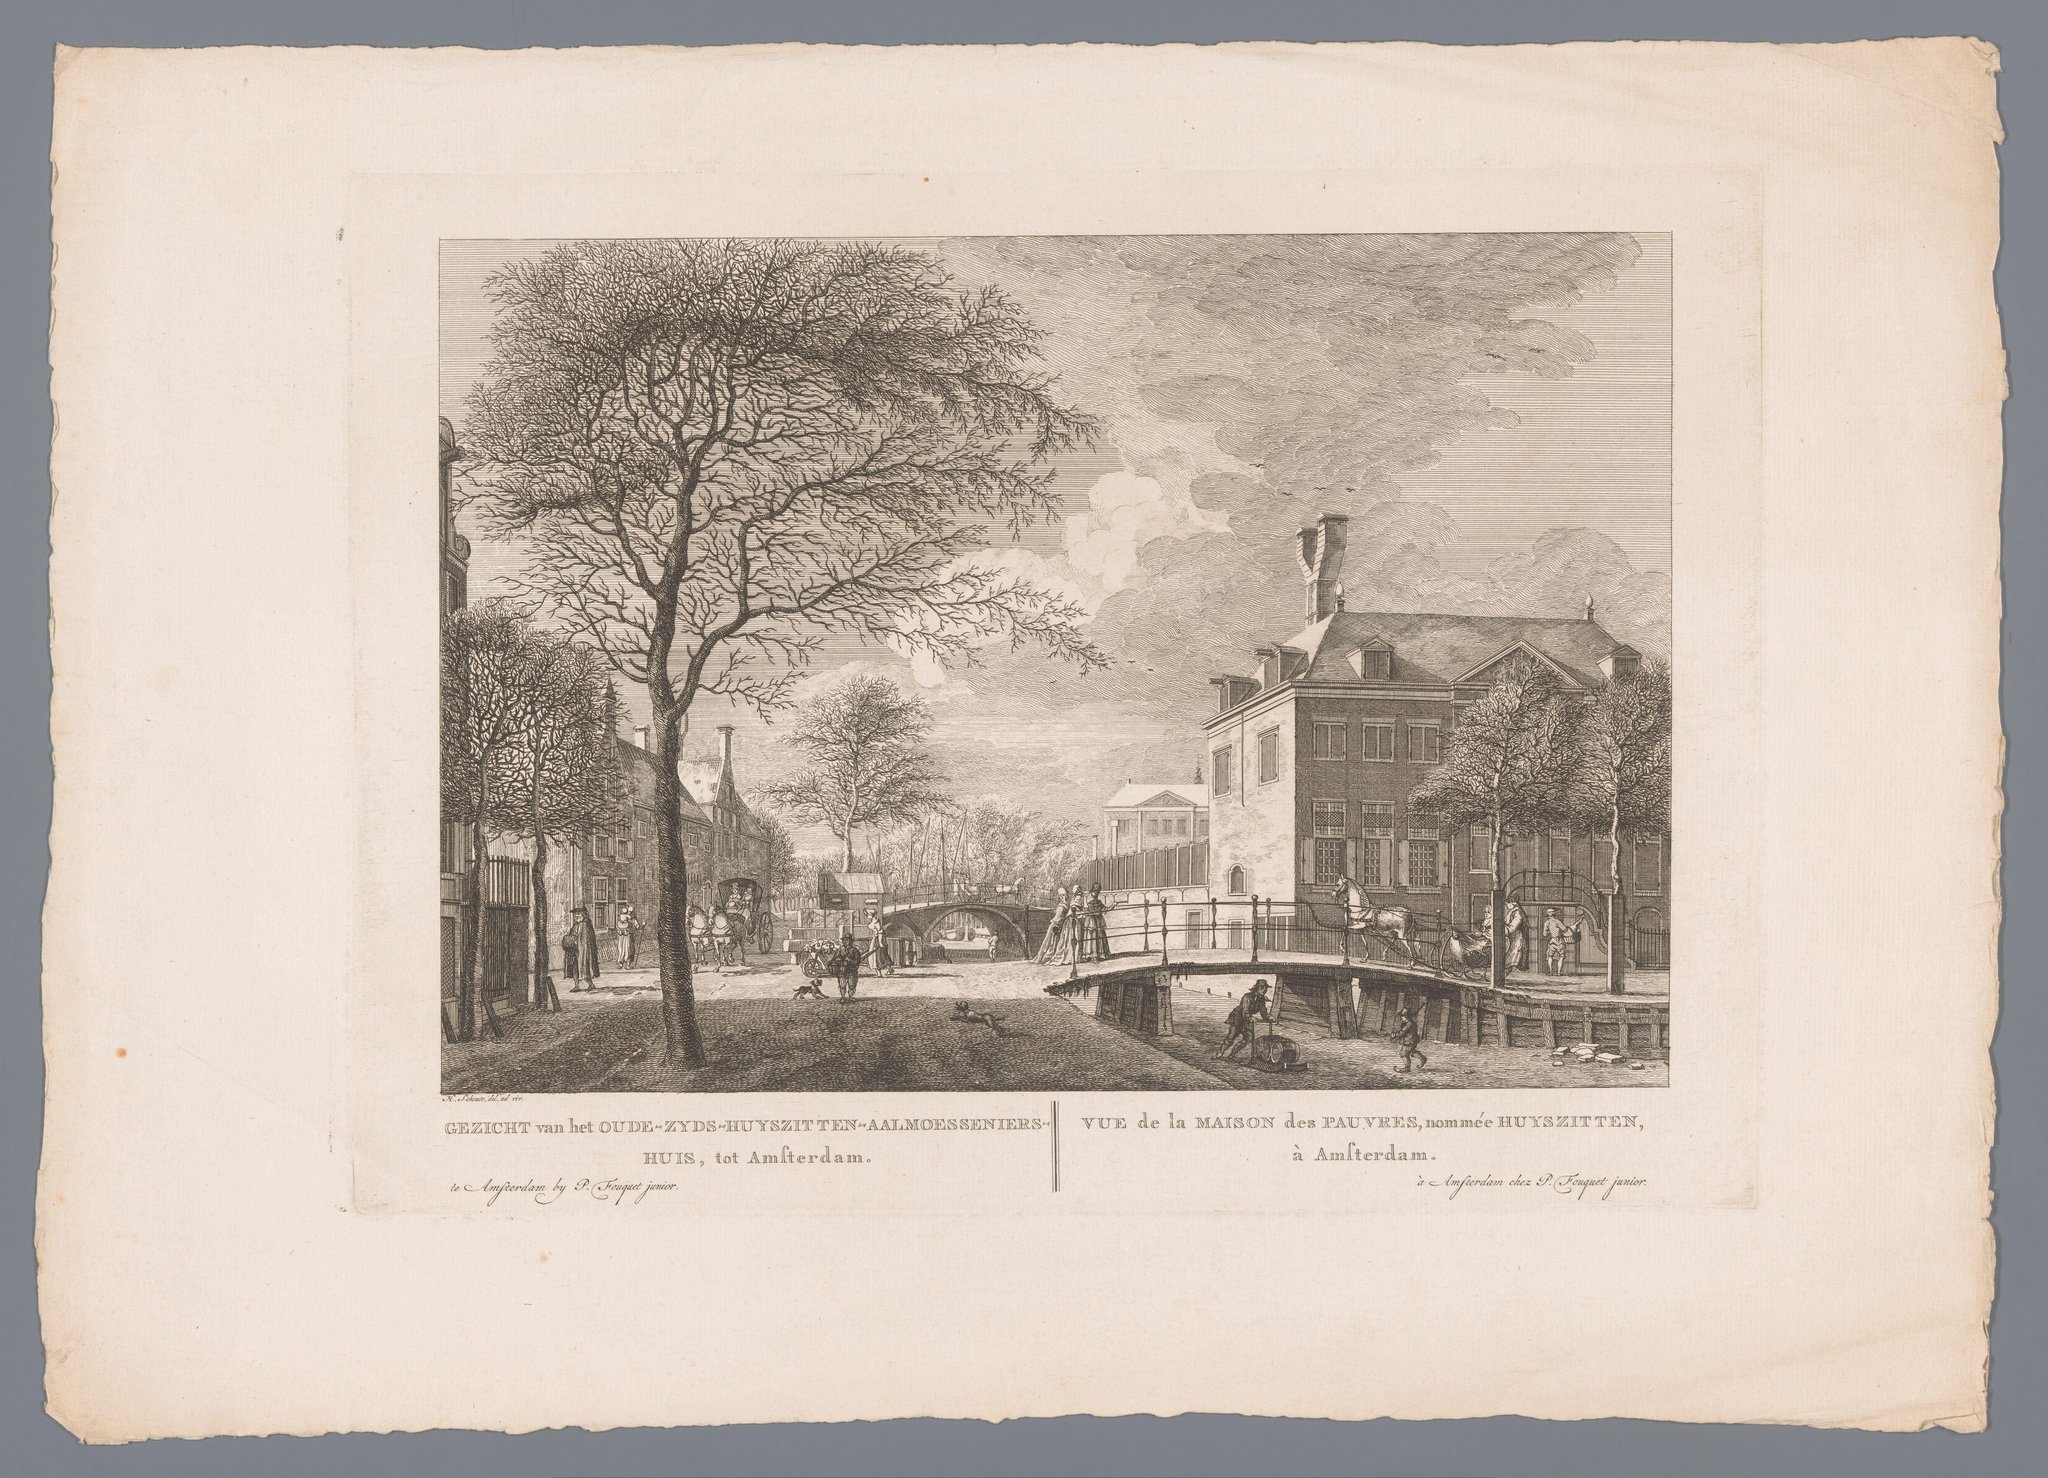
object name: book illustration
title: Gezicht van het Oude-zyds-huyszitten-aalmoesseniers-huis, tot Amsterdam / Vue de la Maison des Pauvres, nommée Huyszitten, à Amsterdam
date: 1778-1783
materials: paper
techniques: engraving, etching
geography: amsterdam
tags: alms-house (dutch: 'hofje')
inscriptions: collector's mark: Lugt 2233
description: Prent uit een van de edities van de Atlas Fouquet: Afbeeldingen van de wyd-vermaarde koopstad Amsterdam benevens des zelvs voornaamste gebouwen en gezigten alle naar het leeven getekend / Receuil des edifices les plus considerables et des plus belles vues, de la fameuse ville d'Amsterdam, dessinées d'après nature. Amsterdam: Pierre Fouquet, 1778-1783. En: Nieuwe atlas, van de voornaamste gebouwen en gezigten der stad Amsterdam, met derzelver beknopte beschryvingen. 2 dln. Amsterdam: Daniël Jean Changuion en Petrus den Hengst [in opdracht van Pierre Fouquet], 1783. Een latere staat komt voor in: Nieuwe atlas, van de voornaamste gebouwen en gezigten der stad Amsterdam. Met derzelver beknopte beschryvingen. Amsterdam: Evert Maaskamp, 1805.